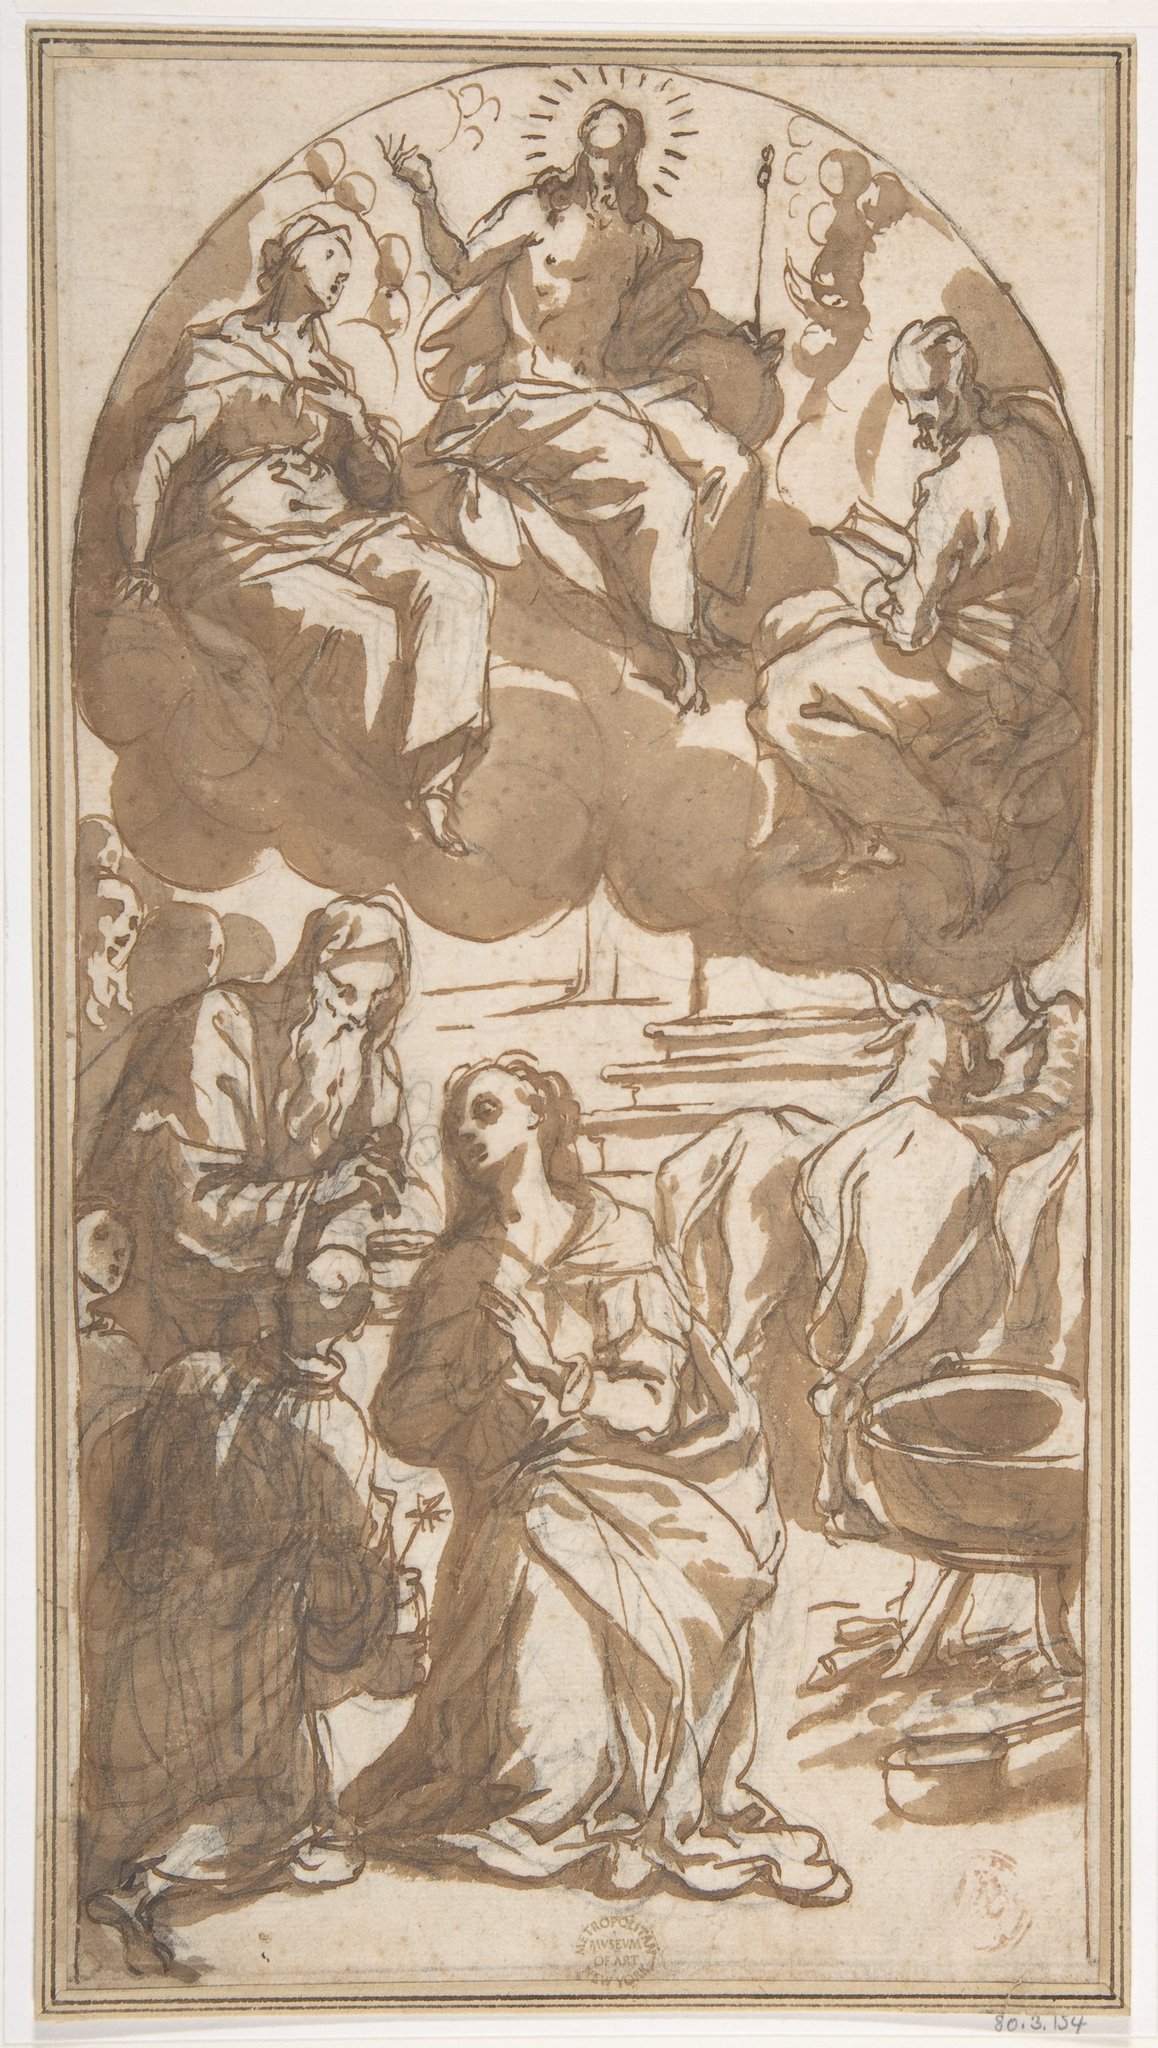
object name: drawing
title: The Martyrdom of Saint Lucy (Her Last Communion before Being Dragged by Oxen)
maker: giovanni battista maganza il giovane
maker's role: artist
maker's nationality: italian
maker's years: 1509-1586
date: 1556-1630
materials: chalk, ink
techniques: brush, pen, wash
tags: animals,men,women,saints